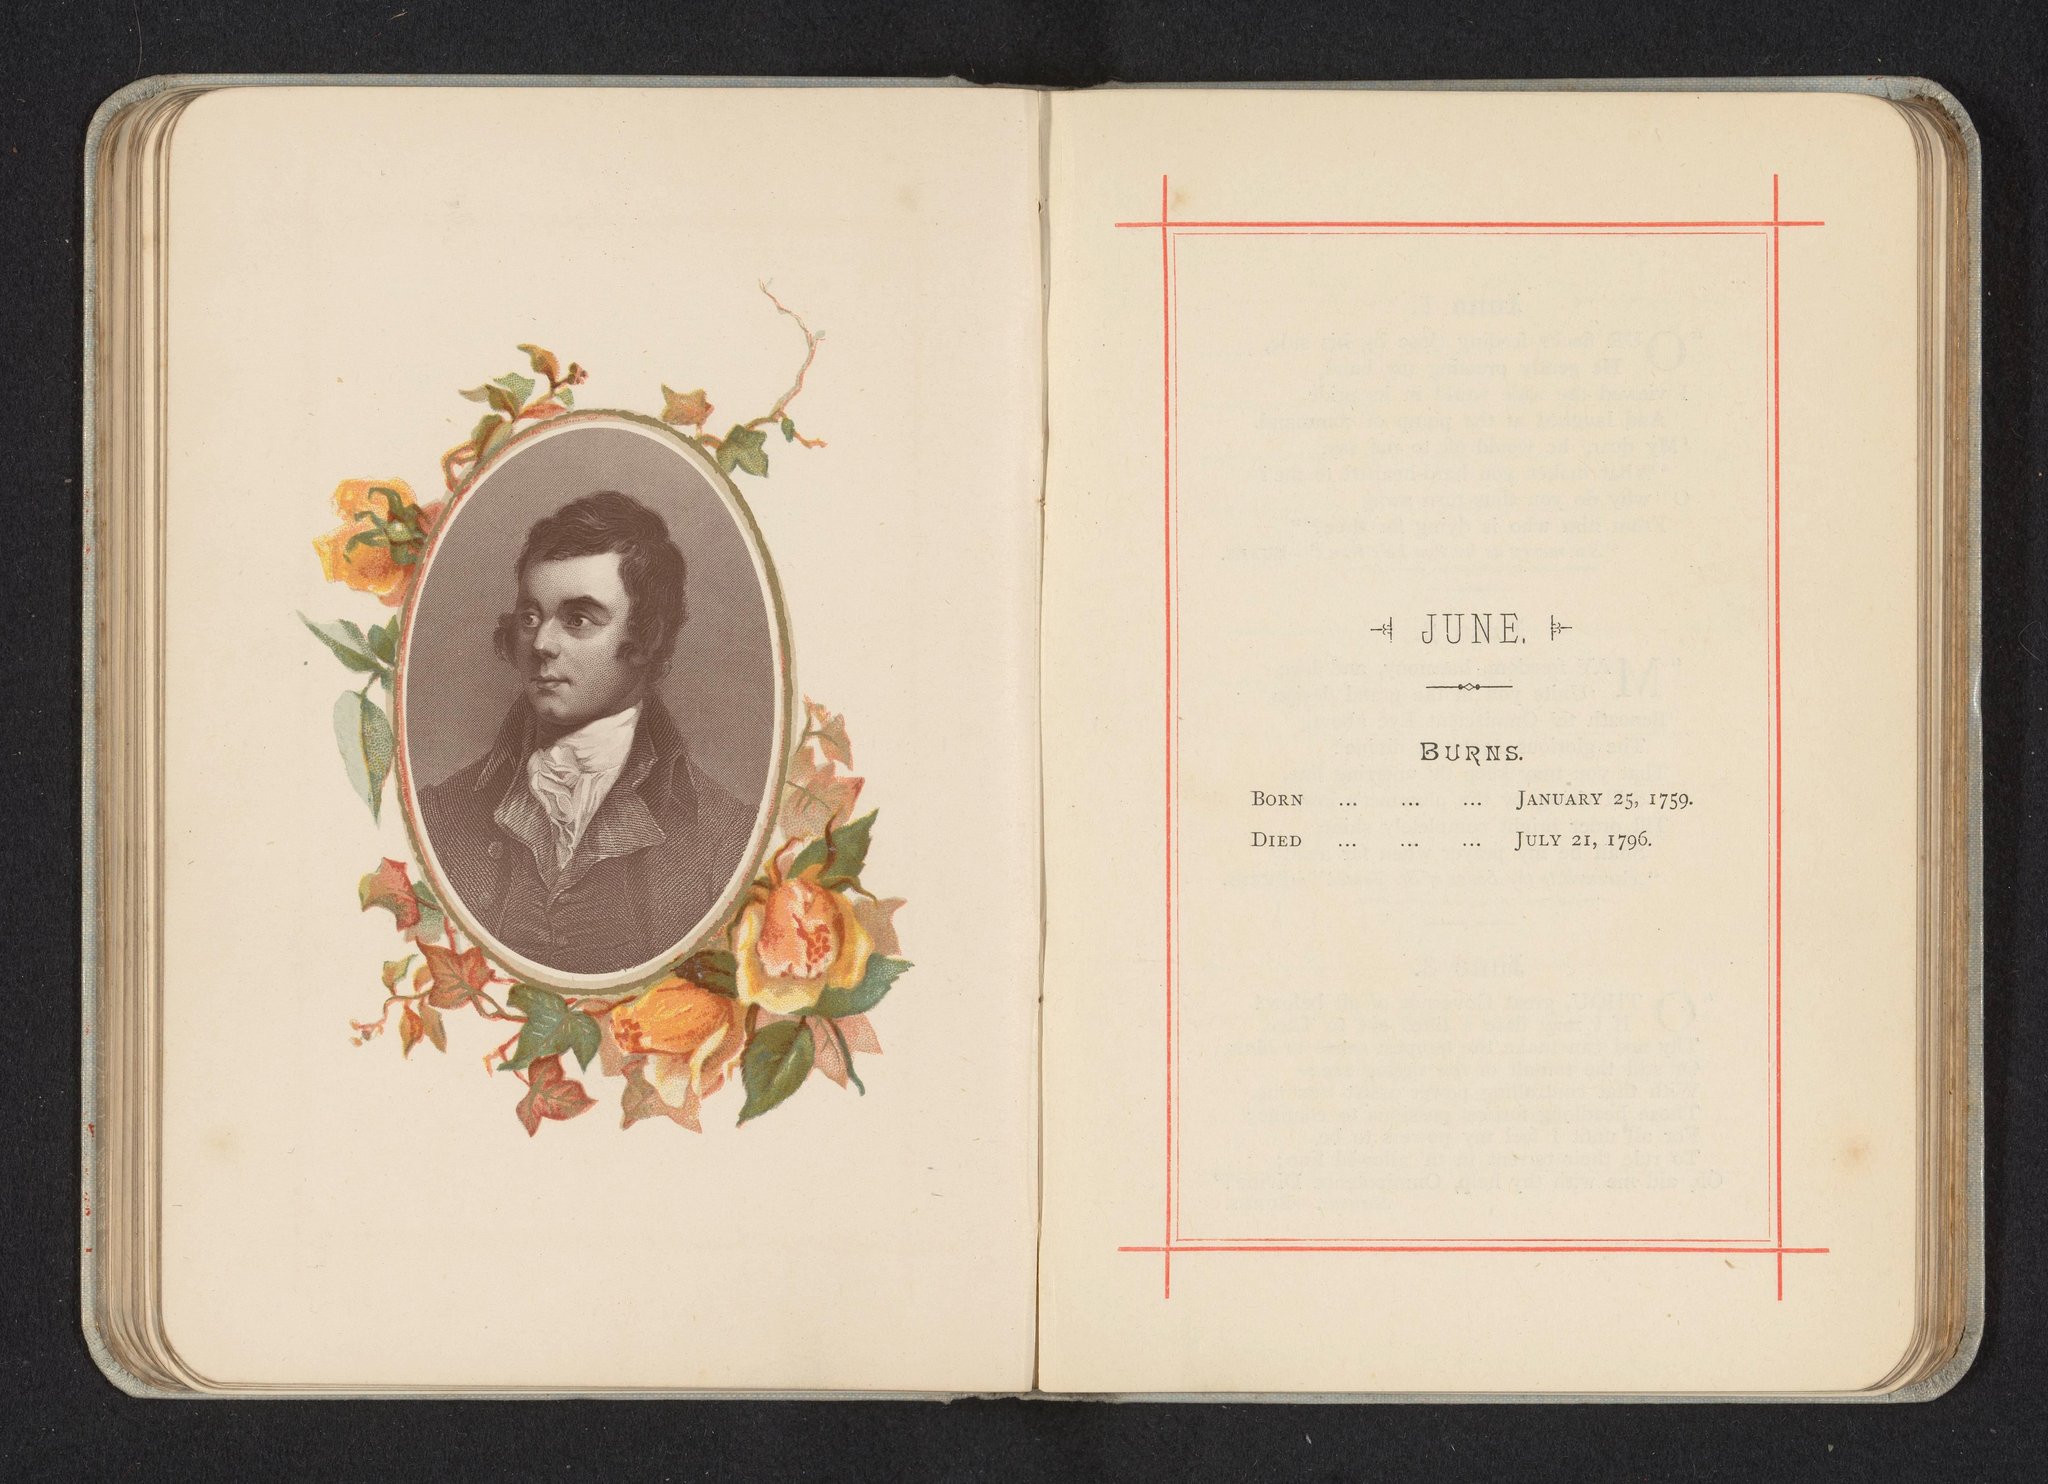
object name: page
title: Fotoreproductie van een prent naar vermoedelijk een portret van Robert Burns door Alexander Nasmyth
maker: Anonymous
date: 1878-1888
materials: paper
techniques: woodburytype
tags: robert burns, writer, poet, author